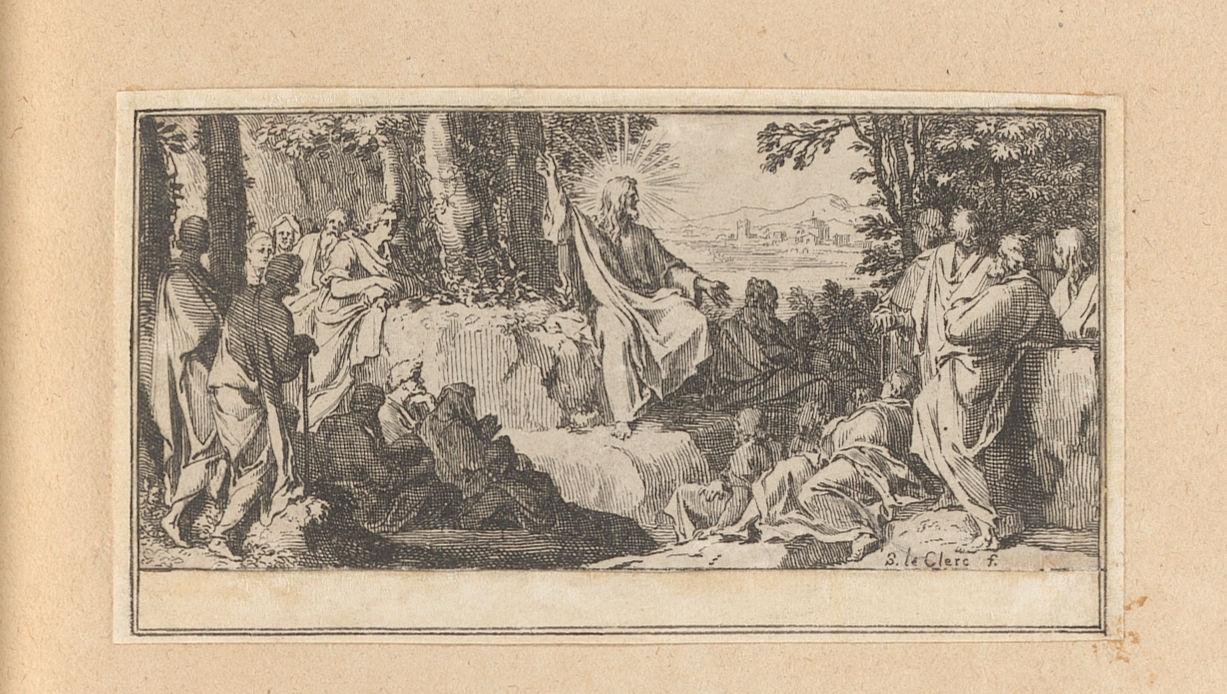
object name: album leaf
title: Prediking van Christus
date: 1683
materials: paper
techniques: etching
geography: paris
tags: christ preaching in the open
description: Vignet uit: Rancé, Le P. Armand-Jean Baptiste Le Bouthillier de. De la sainteté et des devoirs de la vie monastique. Parijs: François Muguet, 1683.